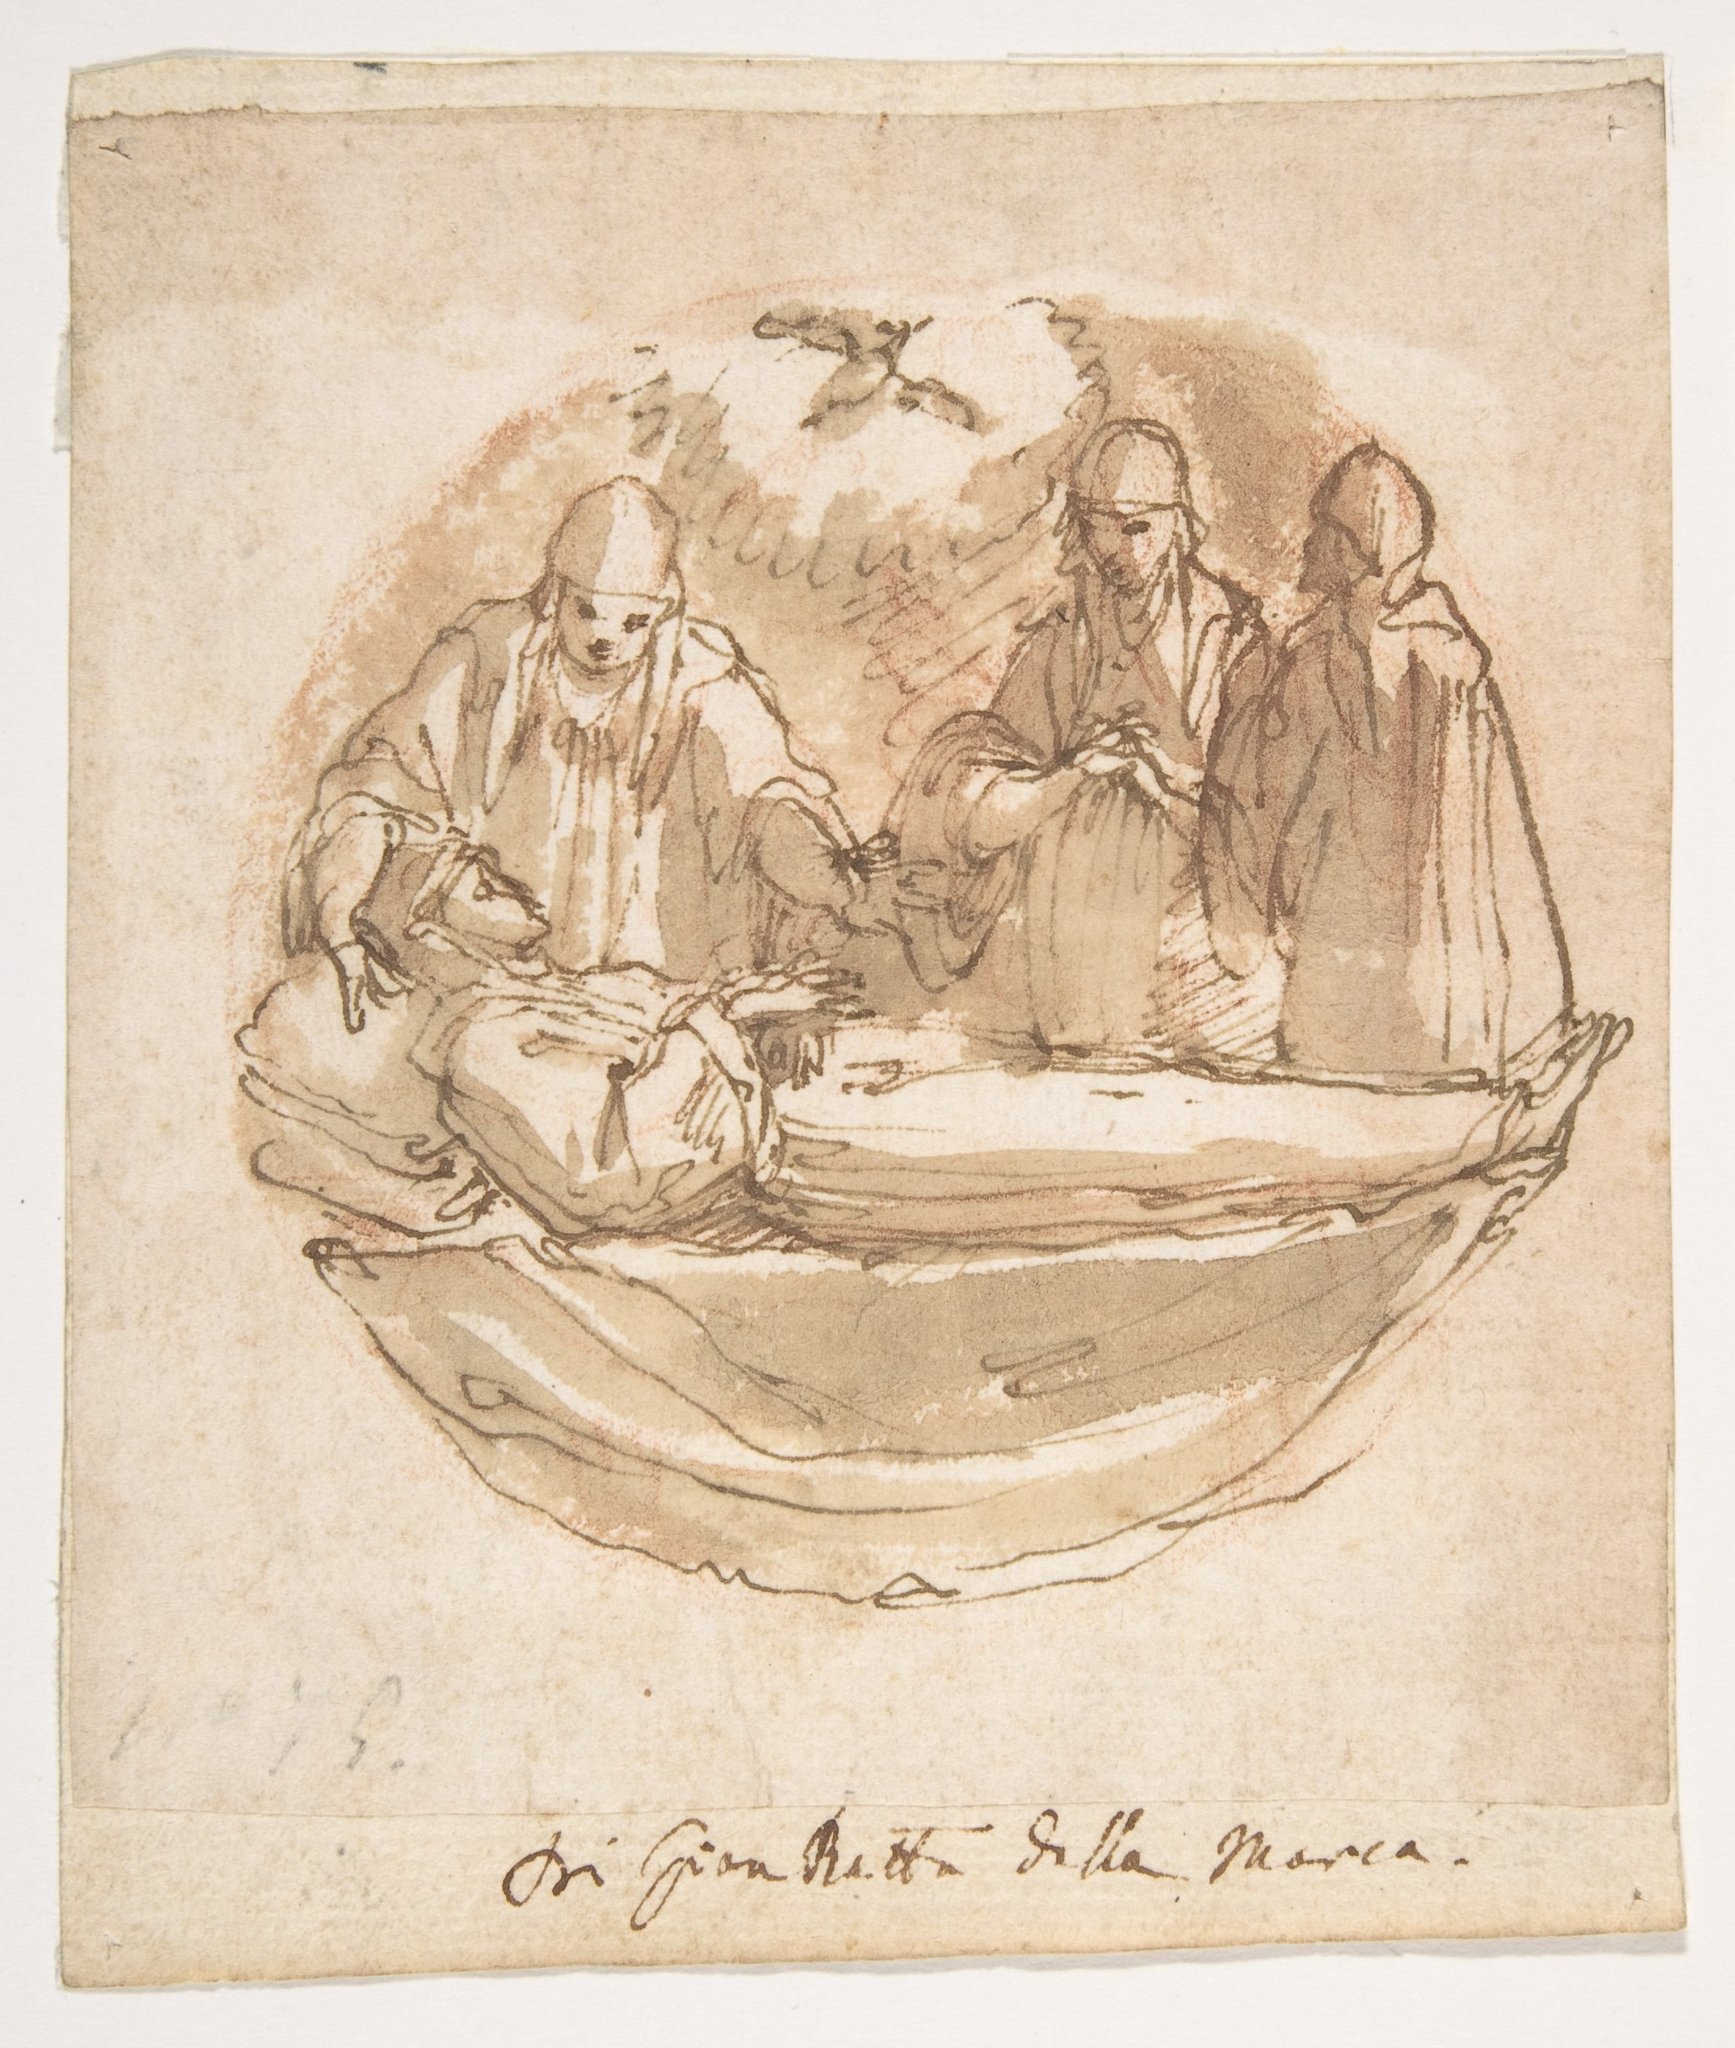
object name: drawing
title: A Nun on Her Deathbed, the Holy Spirit Above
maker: giovanni battista lombardelli (giovanni battista della marca, "il montano")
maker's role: artist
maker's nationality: italian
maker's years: 1532-1587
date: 1532-1587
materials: chalk, ink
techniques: brush, pen, wash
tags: women,death,beds